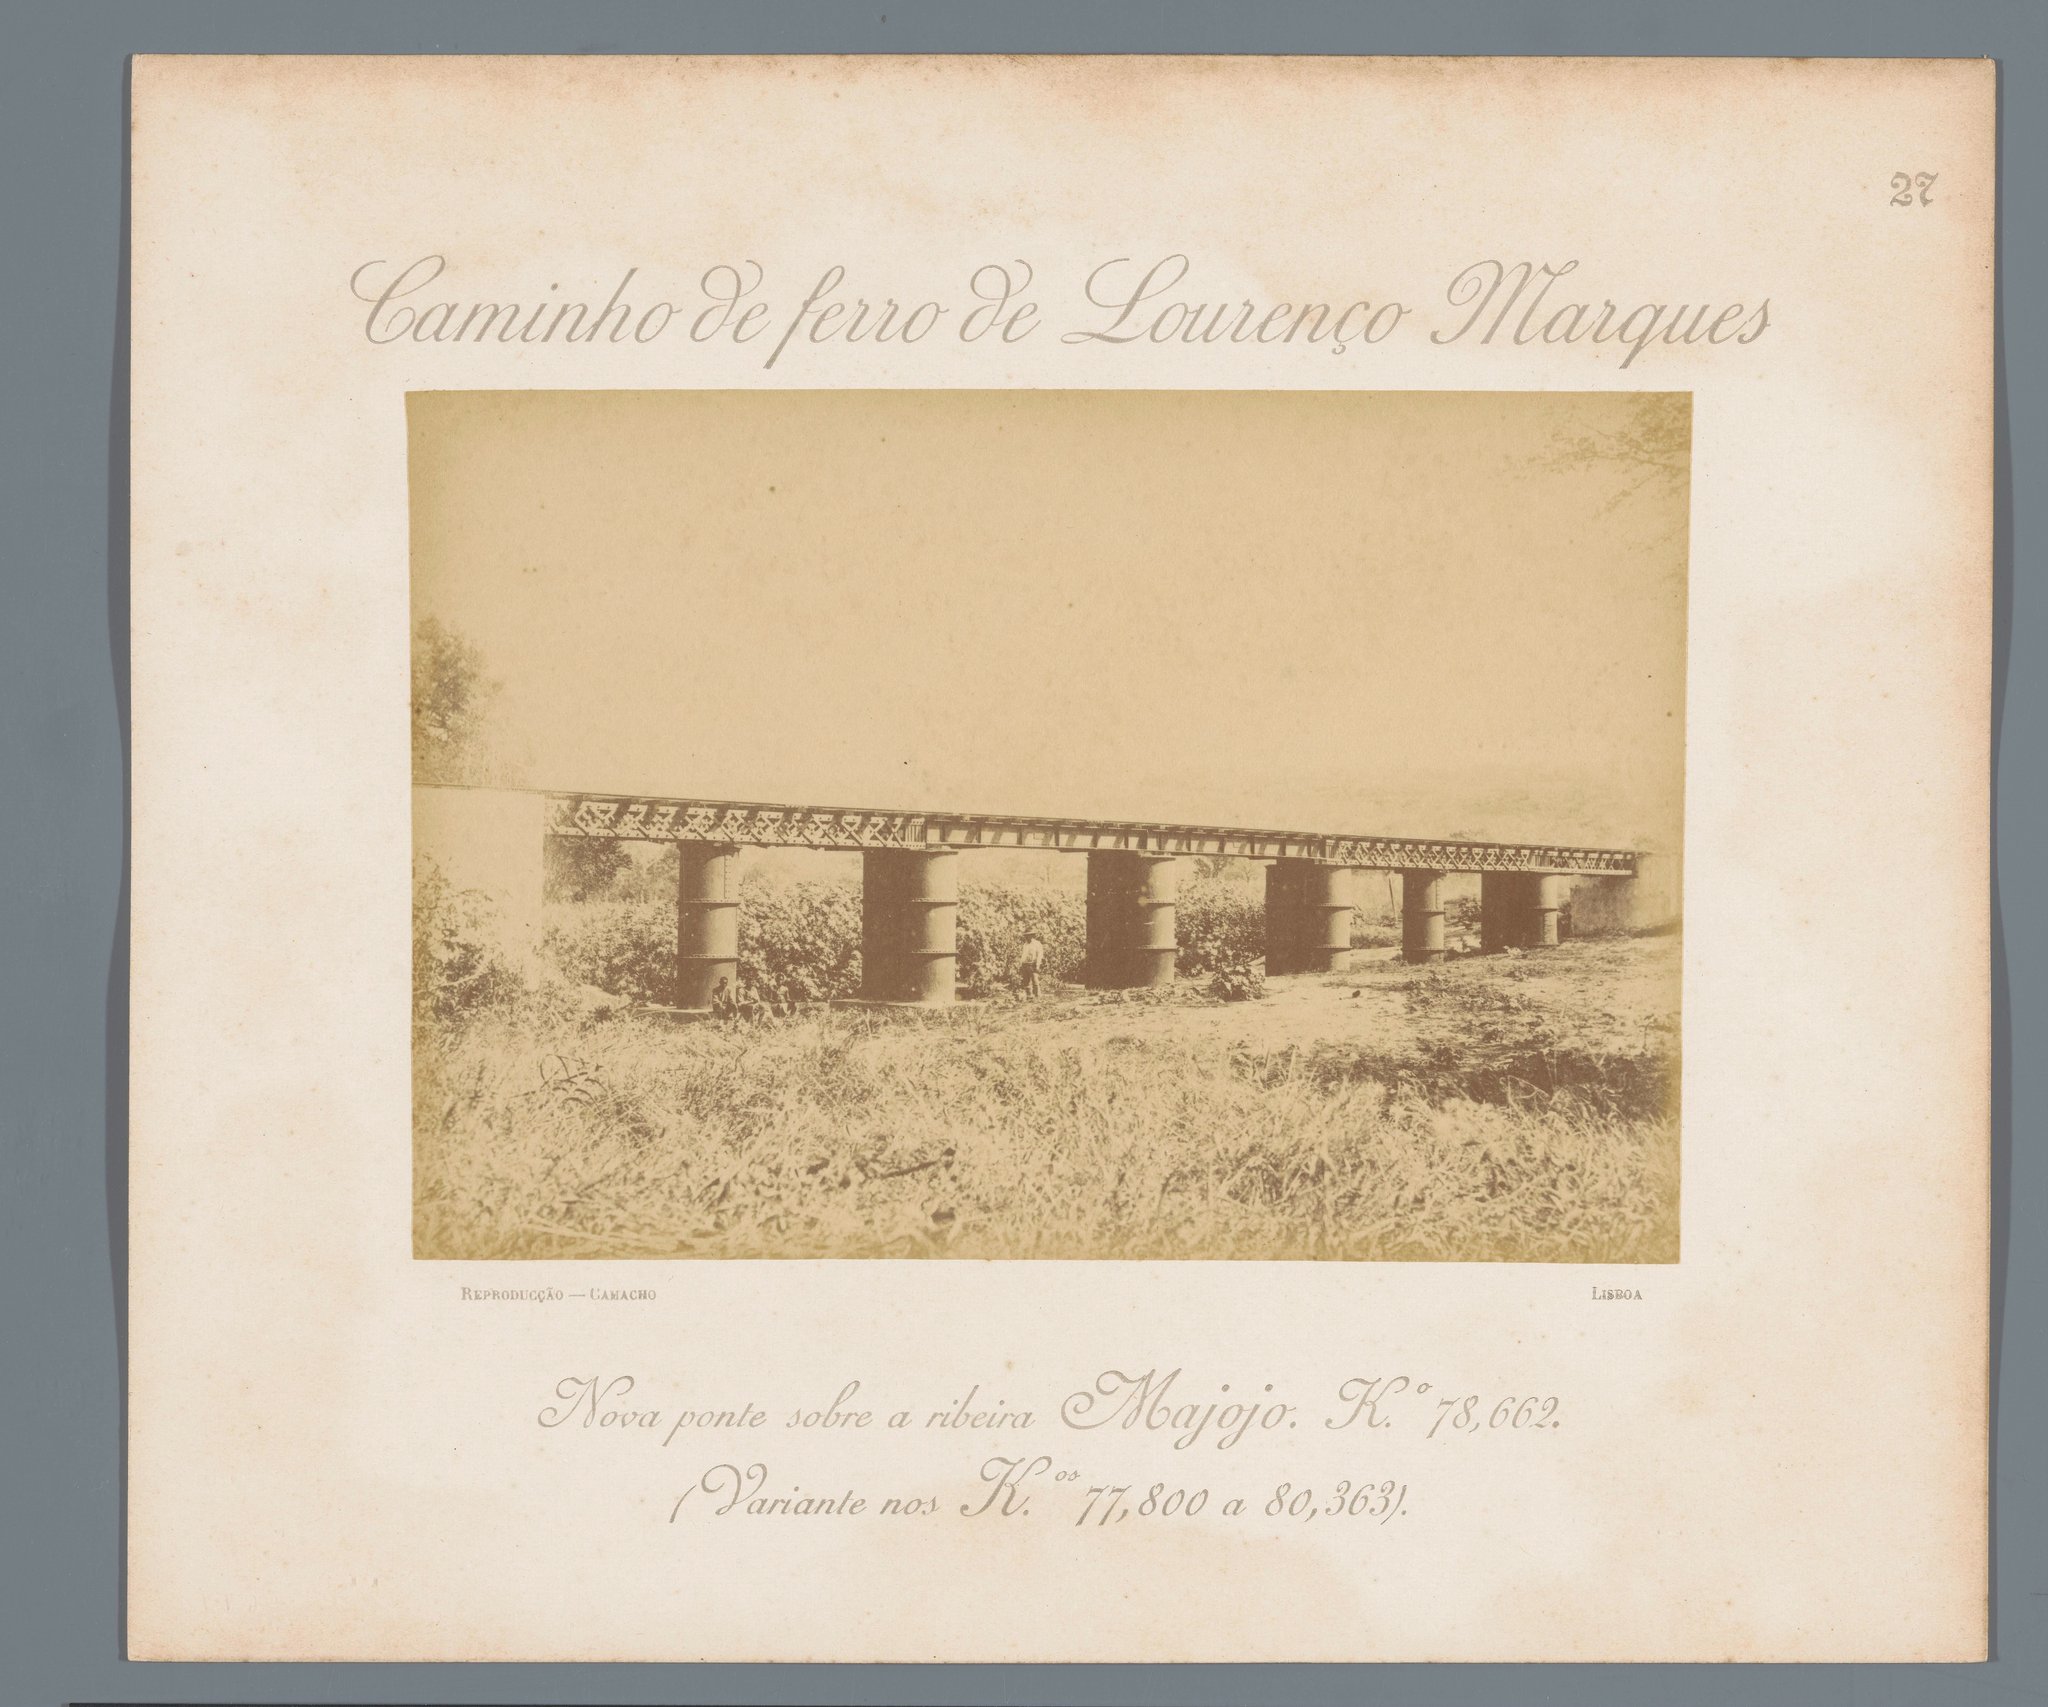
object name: photograph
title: Nova ponte sobre a ribeira Majojo. K. º78,662. (Variante nos K. º77,800 a 80,363)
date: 1886-1895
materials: photographic support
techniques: albumen print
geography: lisbon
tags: landscape with bridge, viaduct or aqueduct, railway, train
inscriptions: number: ‘27’